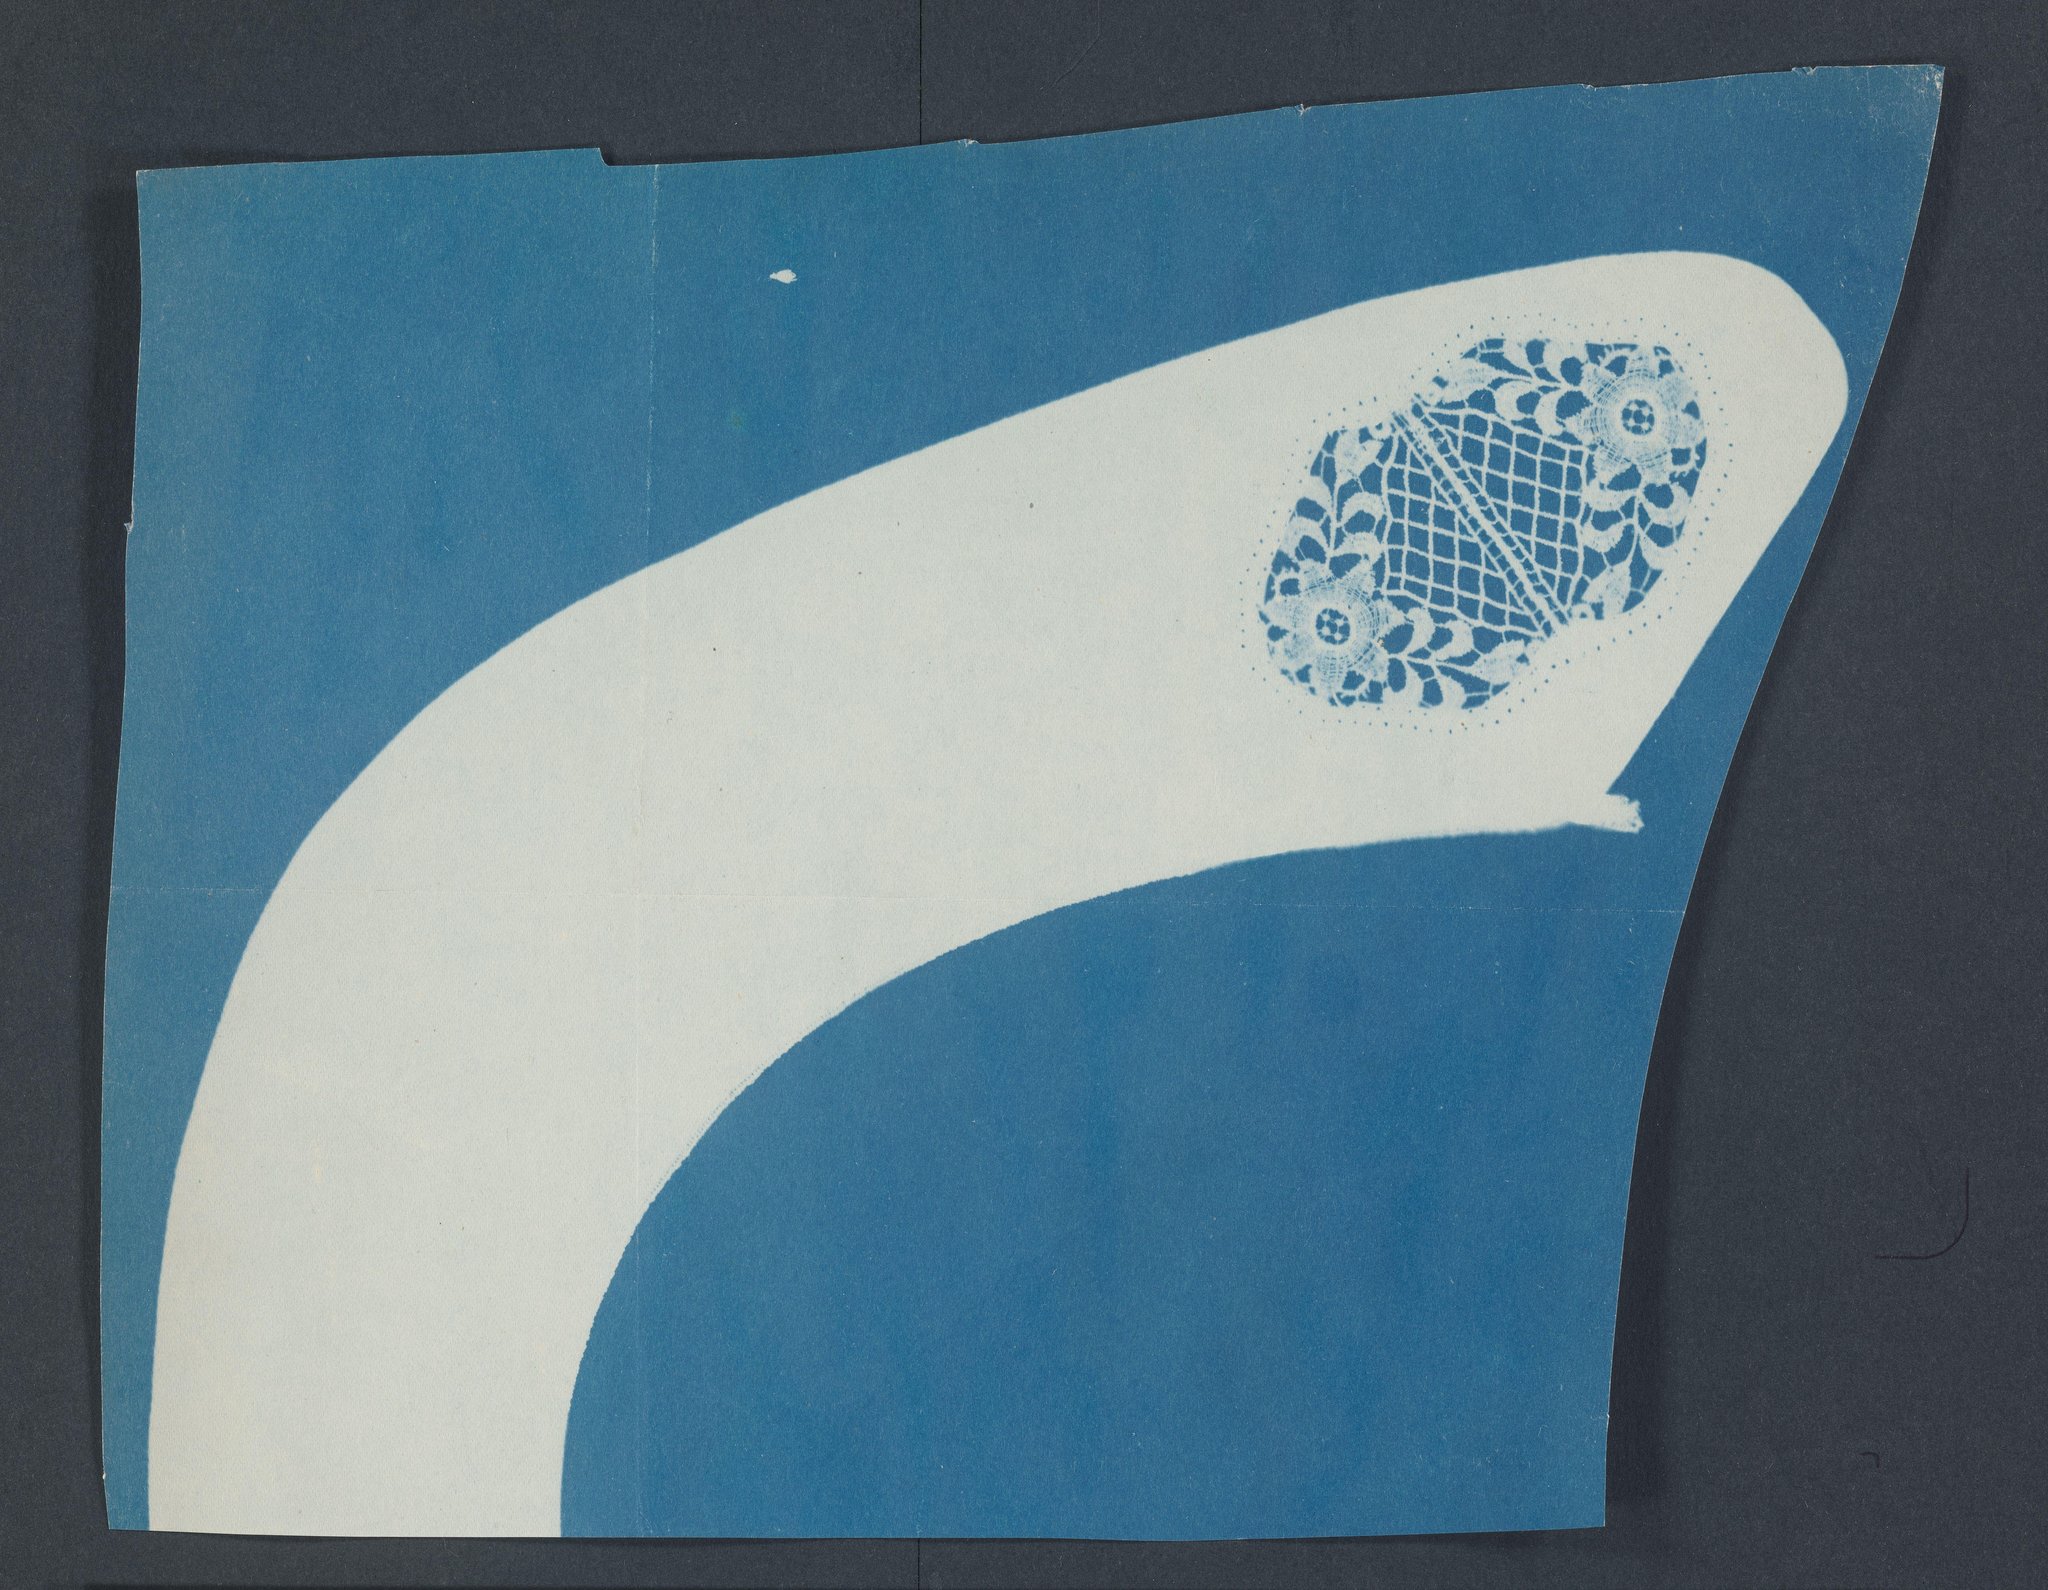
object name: photogram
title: Kant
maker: Anonymous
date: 1900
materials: paper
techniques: cyanotype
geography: france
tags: lace